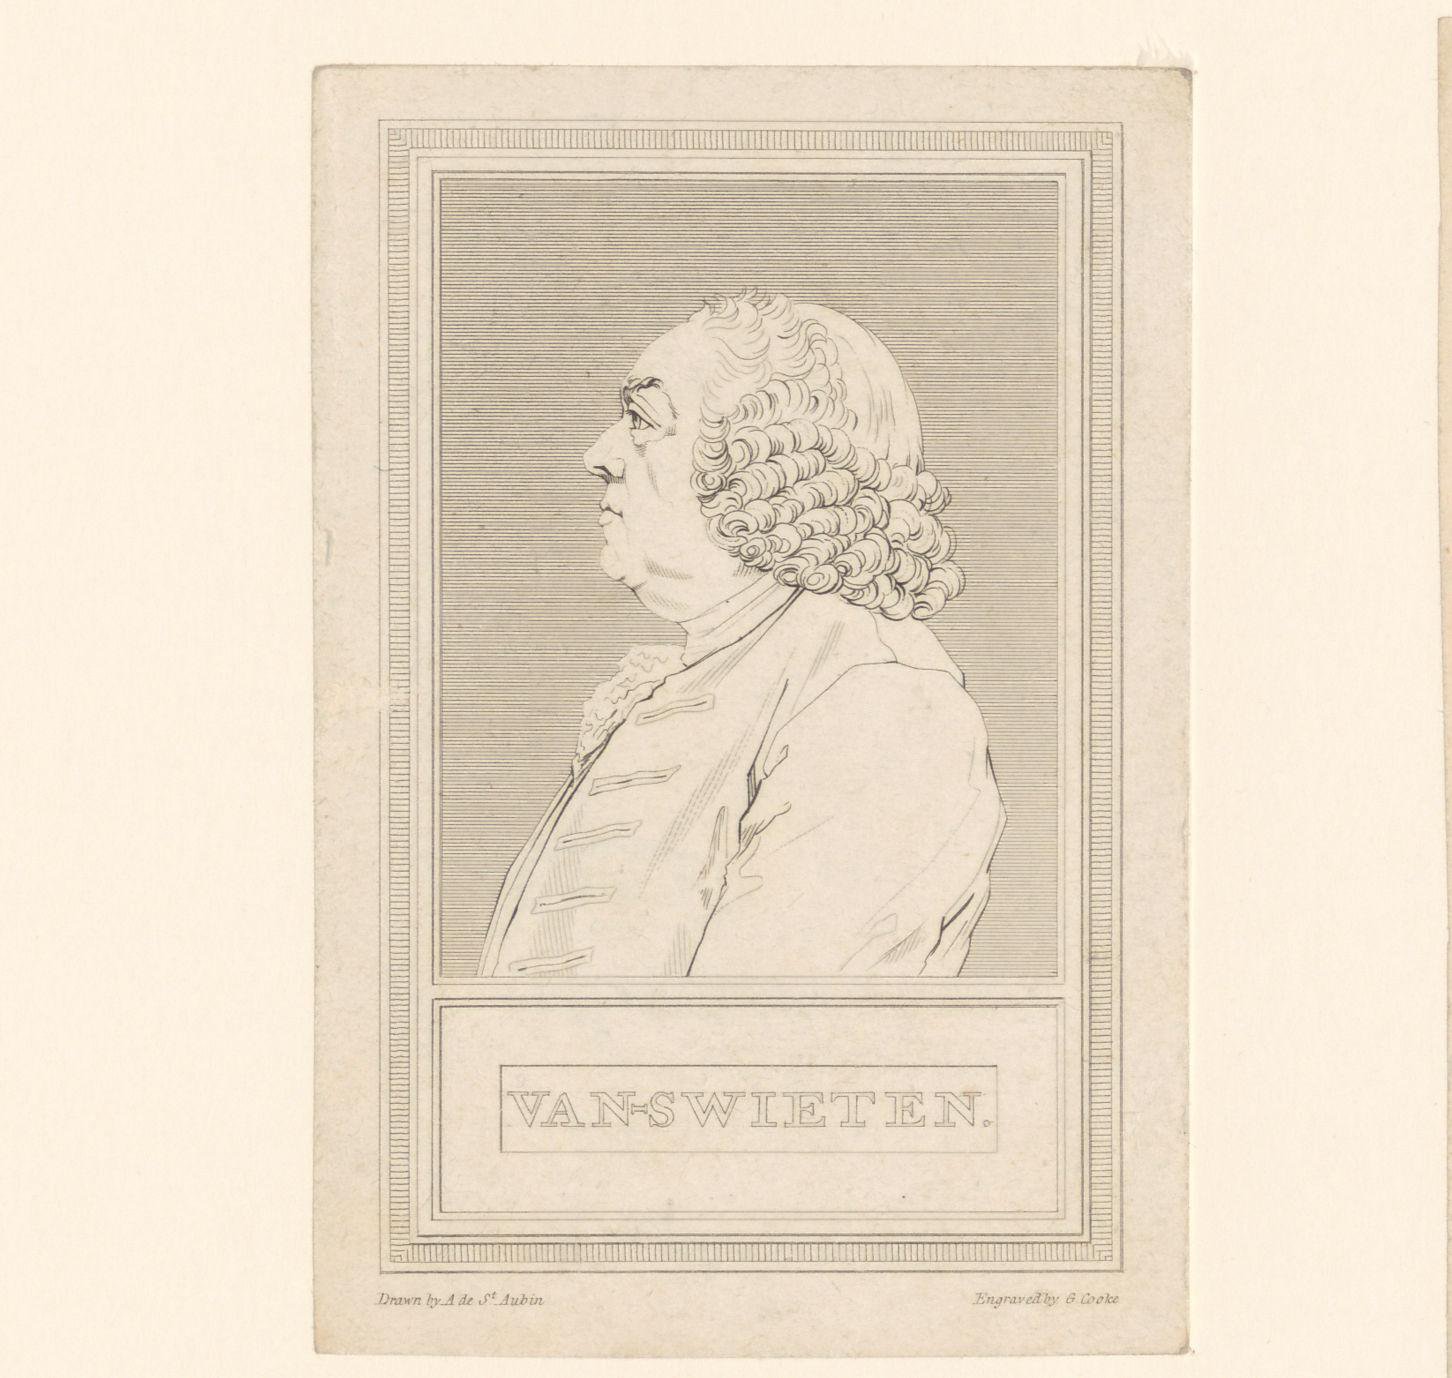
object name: book illustration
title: Portret van Gerard van Swieten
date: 1807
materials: paper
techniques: etching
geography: london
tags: leiden, vienna, historical persons, physician, doctor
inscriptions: collector's mark: Lugt 2228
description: Prent uit: The Historic Gallery of Portraits and Paintings (...). Londen: Vernor, Hood & Sharpe, 1807, dl. 1.